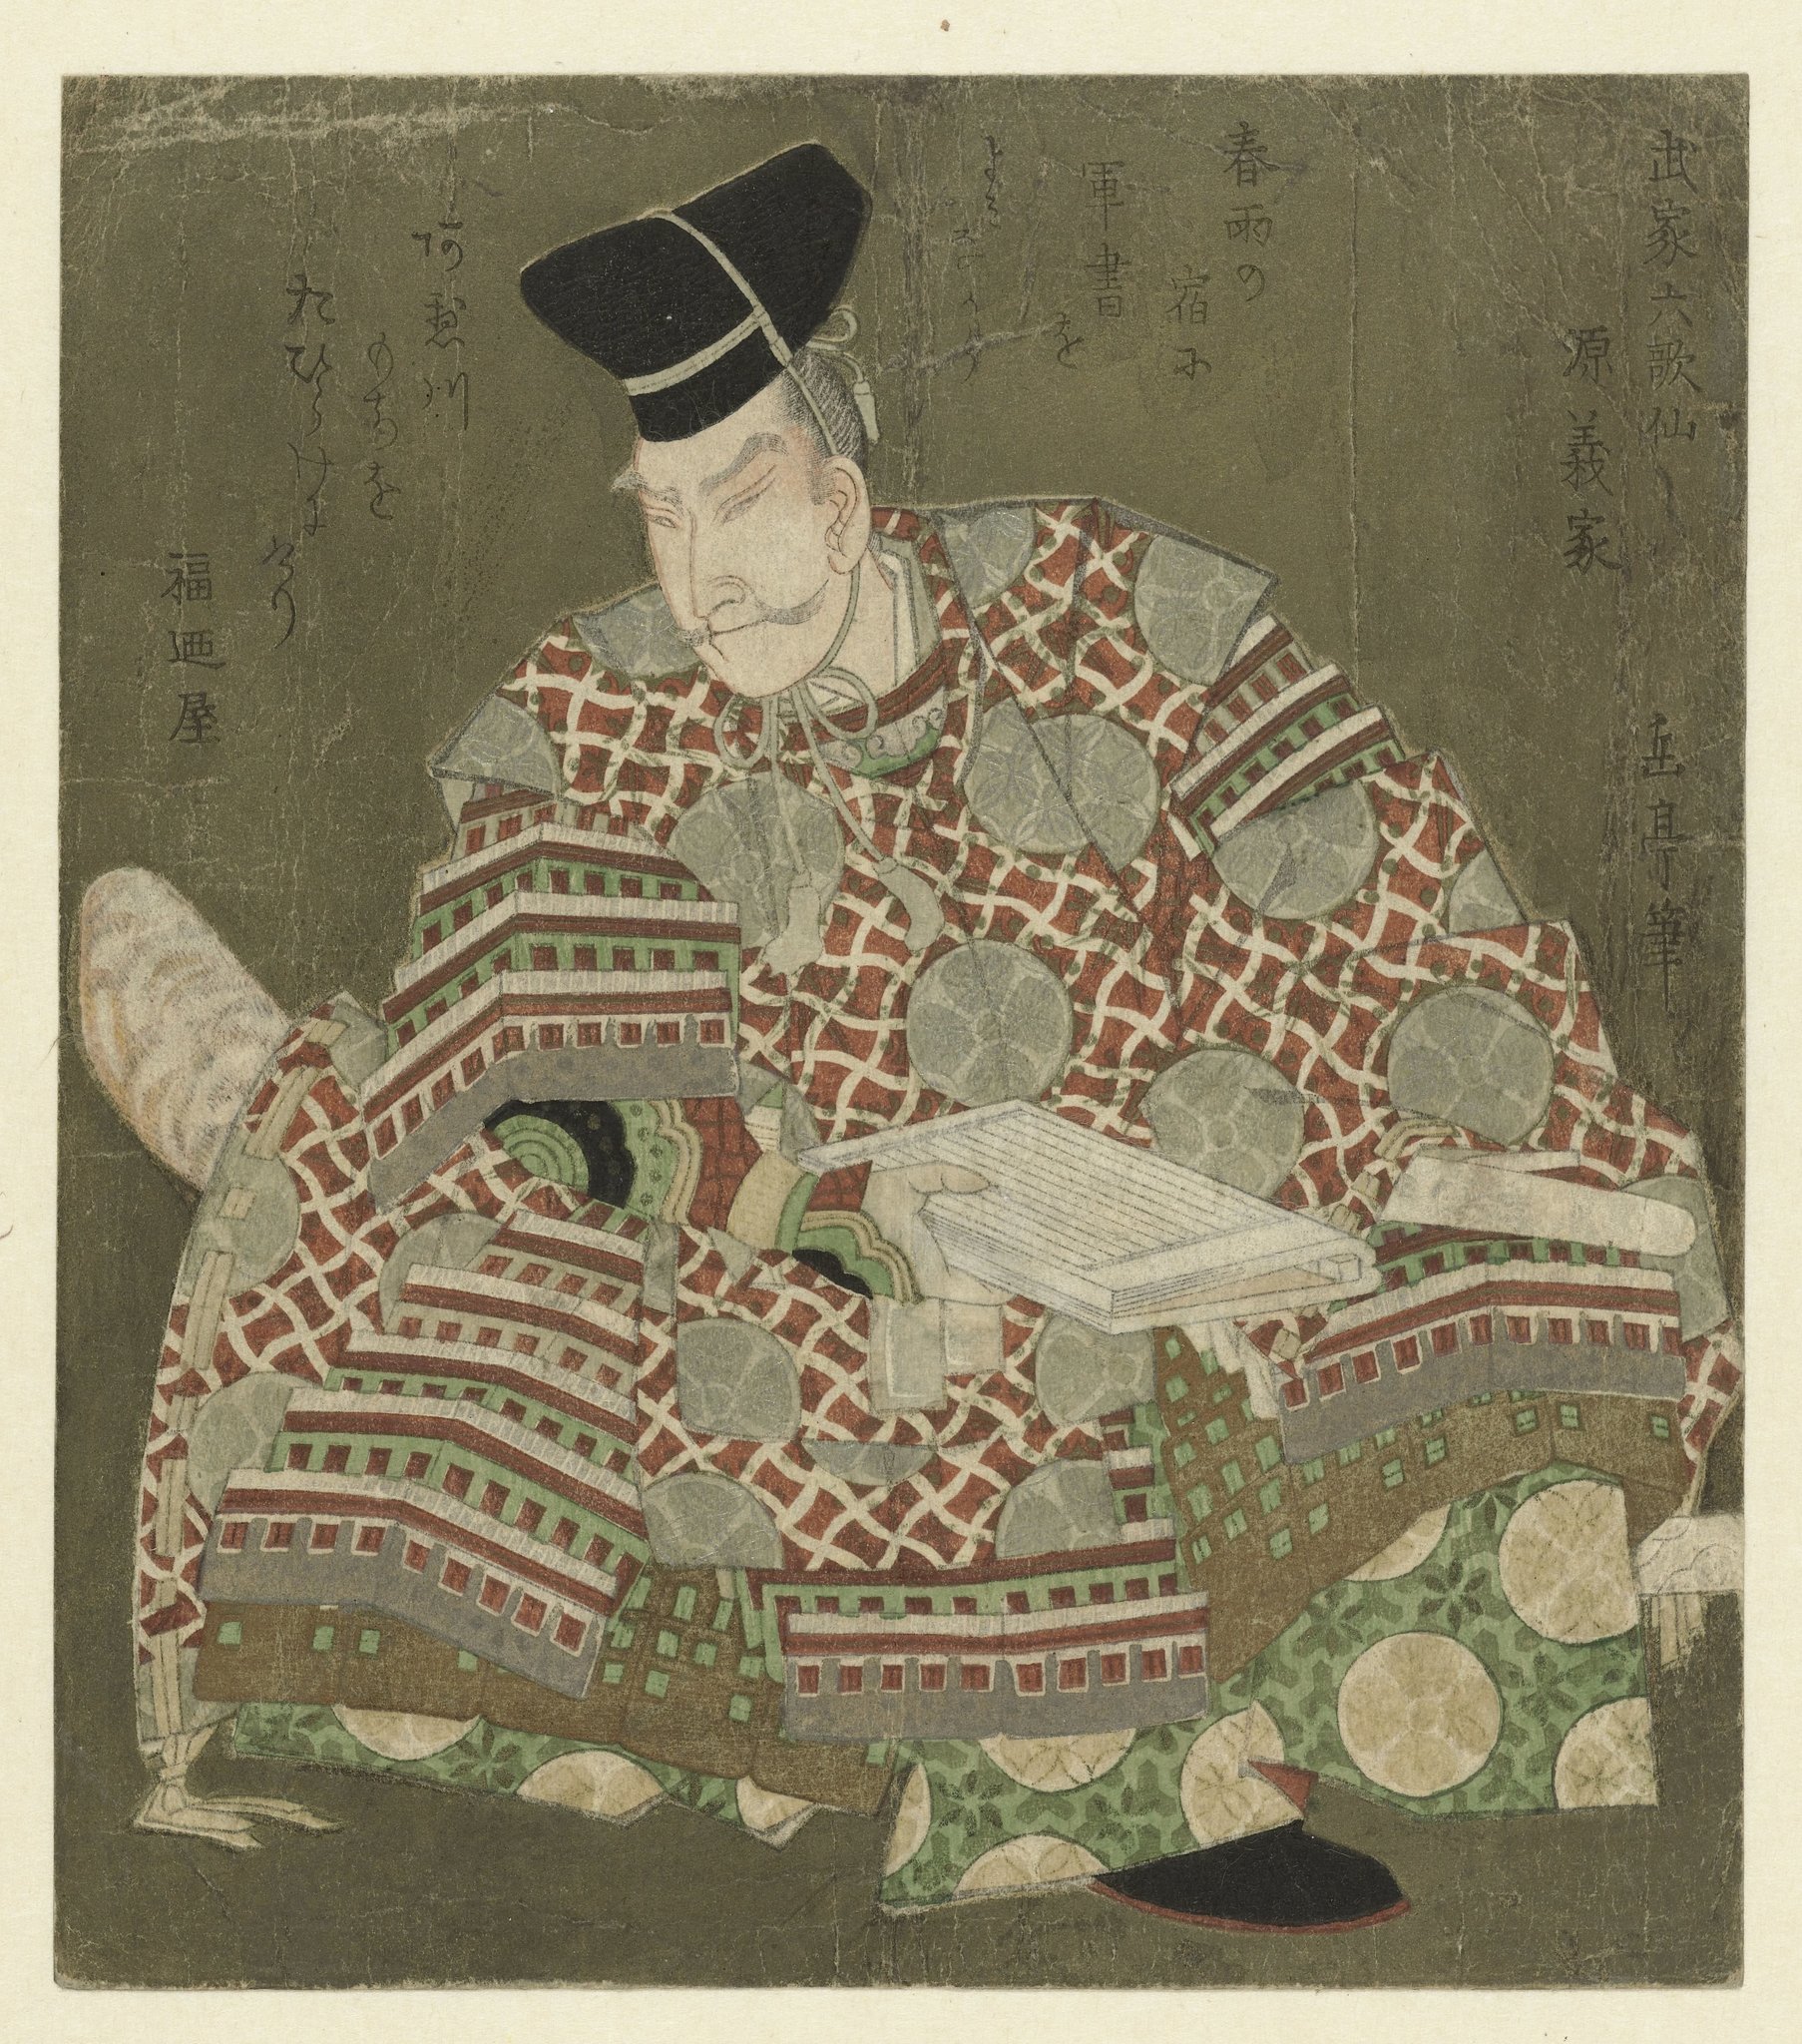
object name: surimono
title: A Seated Warrior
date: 1825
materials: paper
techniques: blind stamped, woodcut, polish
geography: japan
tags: sitting figure, book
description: Een surimono is een luxe uitgevoerde prent waarop beeld met één of meerdere gedichten gecombineerd is. Bij het drukken van een surimono werd vaak gebruik gemaakt van dikker papier, blinddruk en metaal pigmenten, zoals koper- en zilverpoeder. De prenten werden vaak in opdracht van dichters gemaakt en als exclusief geschenk aan vrienden en relaties gegeven.